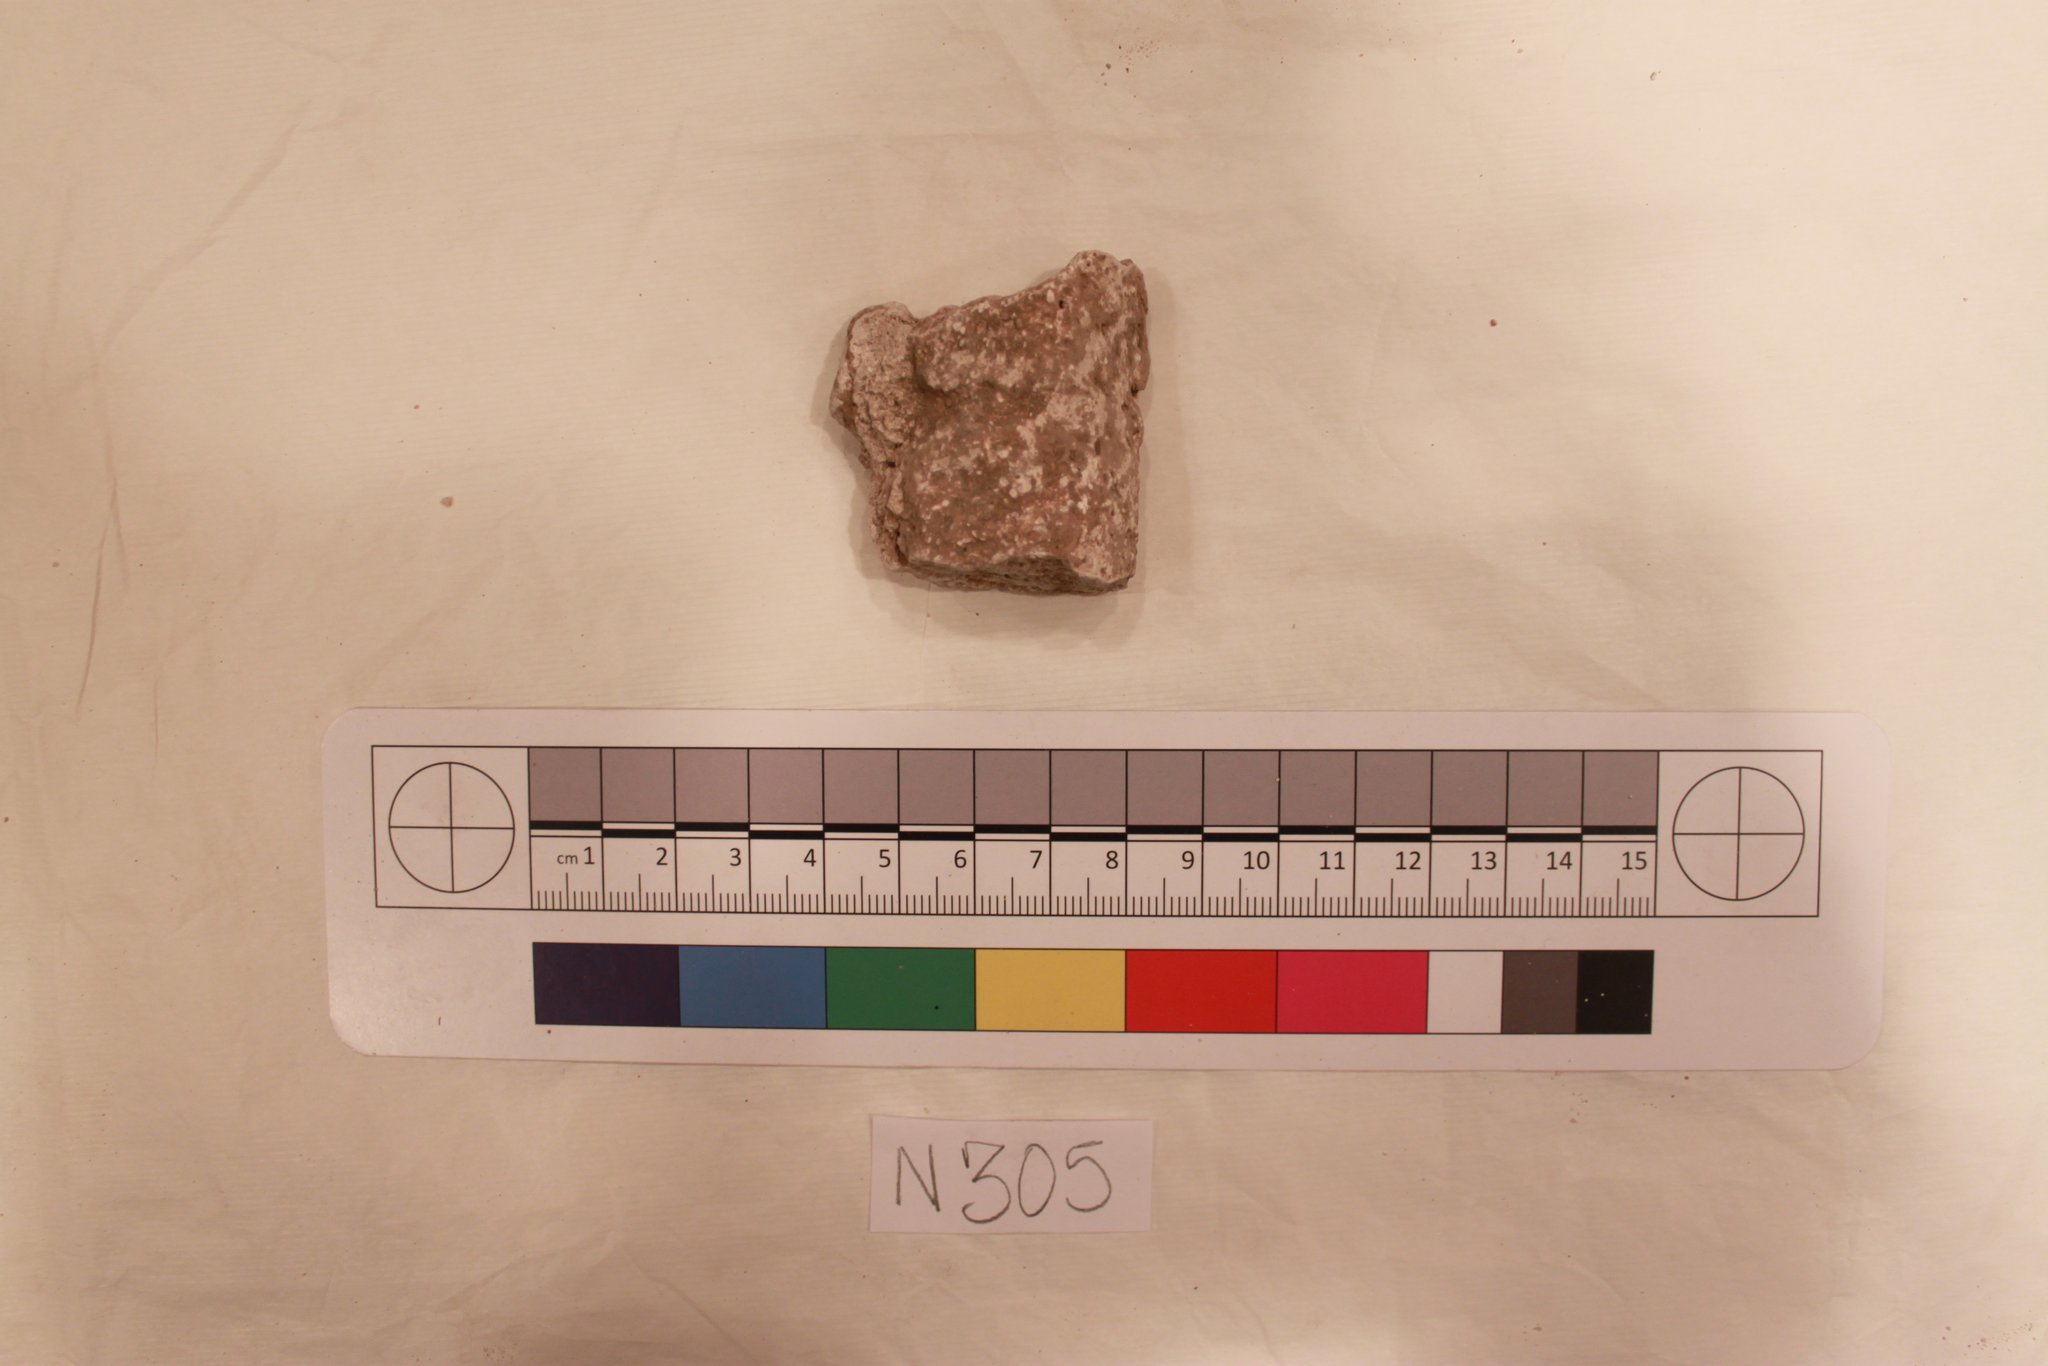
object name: fragment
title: Stucco Fragment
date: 701-1200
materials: plaster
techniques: carving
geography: iran